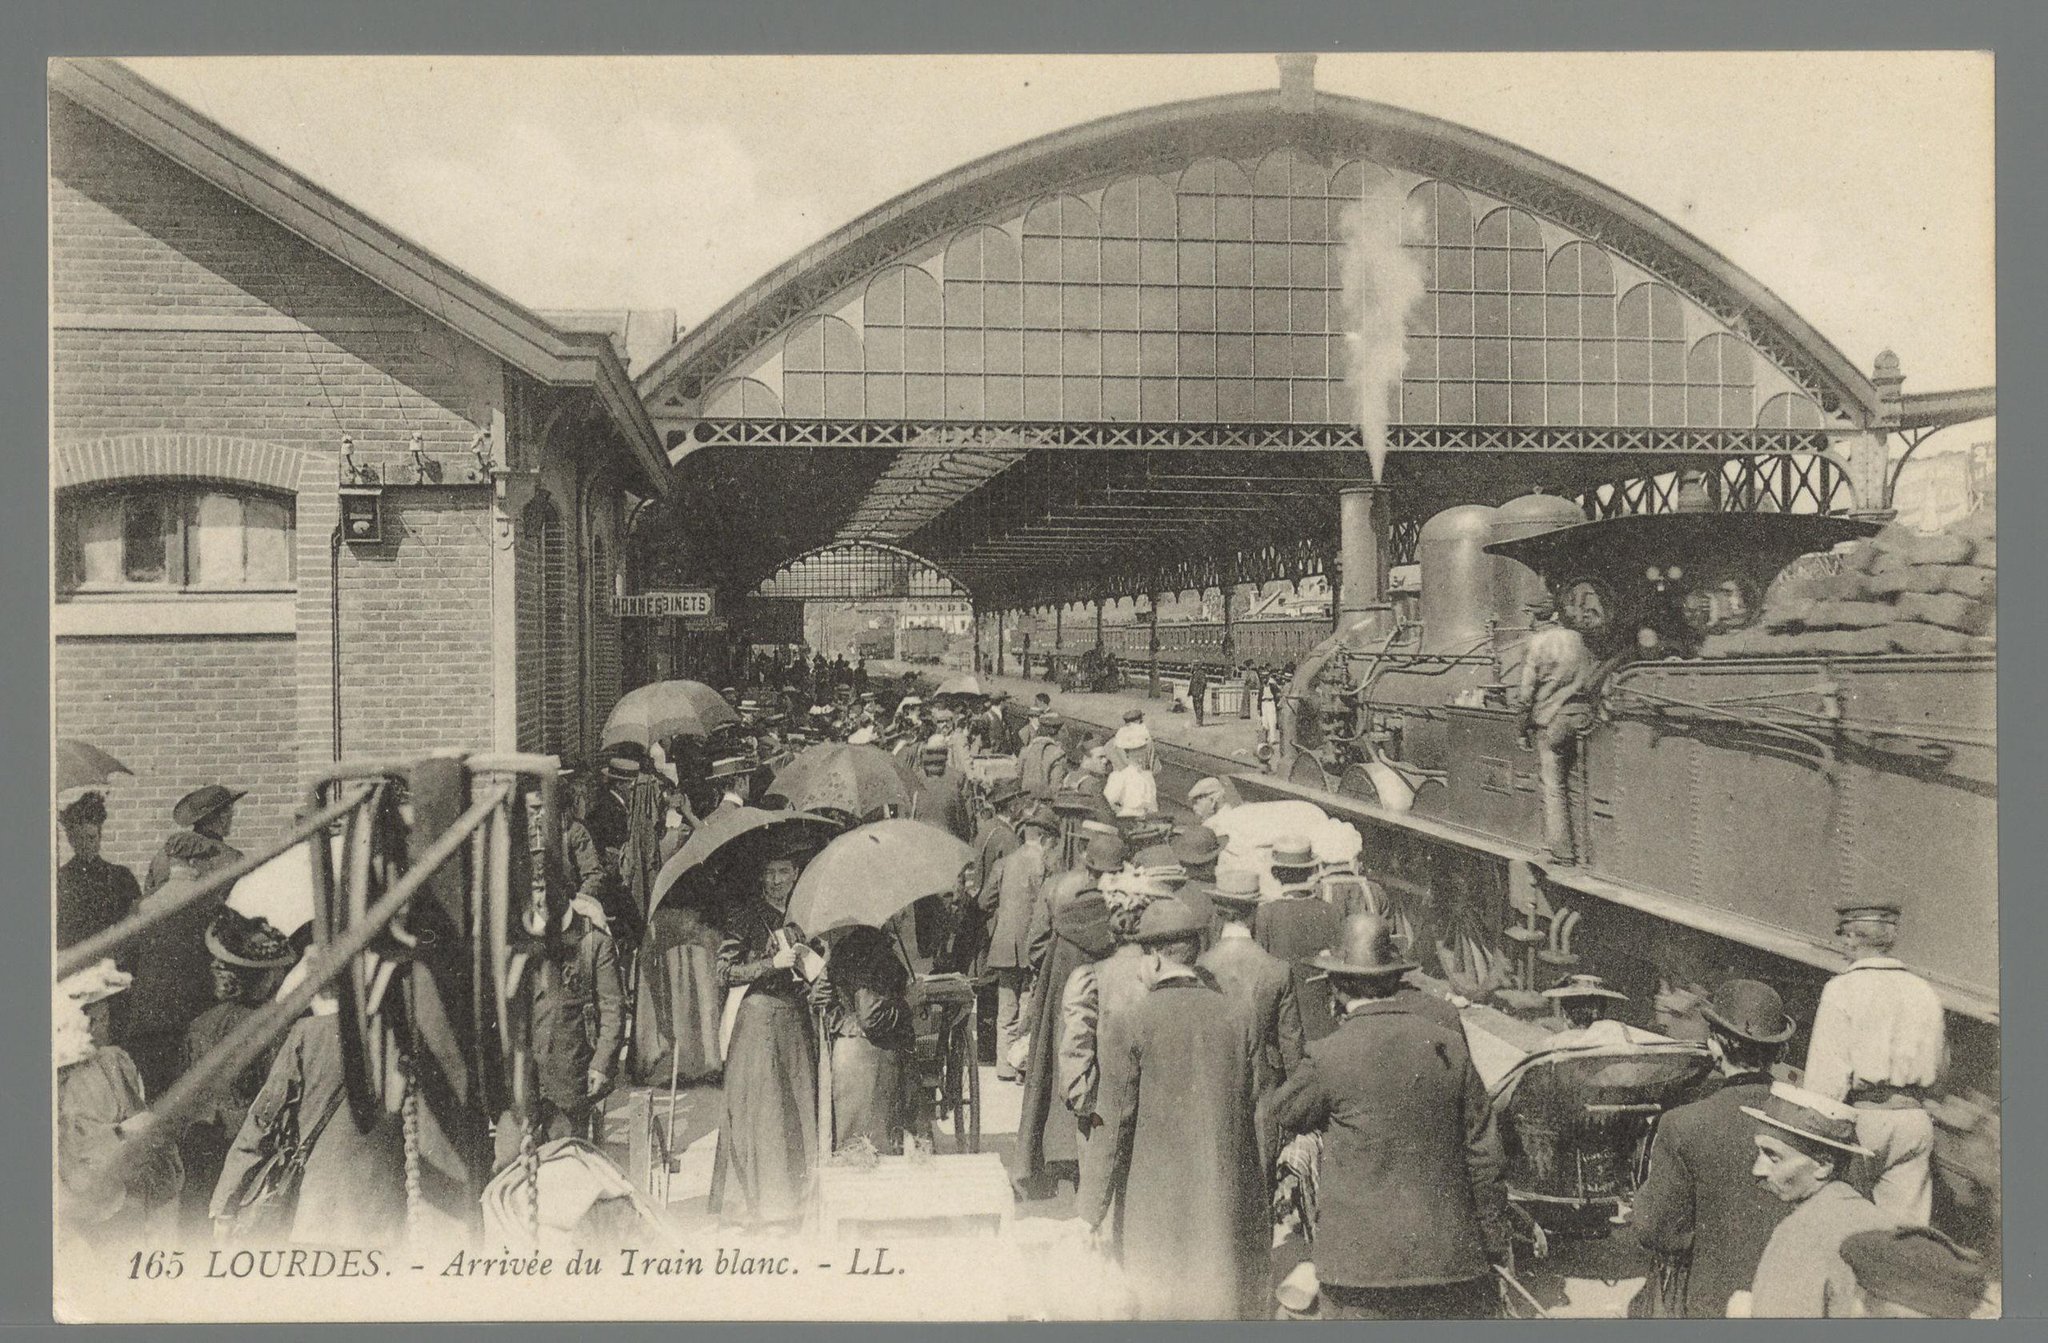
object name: ansichtkaart, prentbriefkaart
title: Lourdes. Arrivée du train blanc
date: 1904-1906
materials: cardboard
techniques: photograph, writing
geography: paris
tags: platform (railway, tramway), passenger train (+ four persons or more ~ traffic and transport)